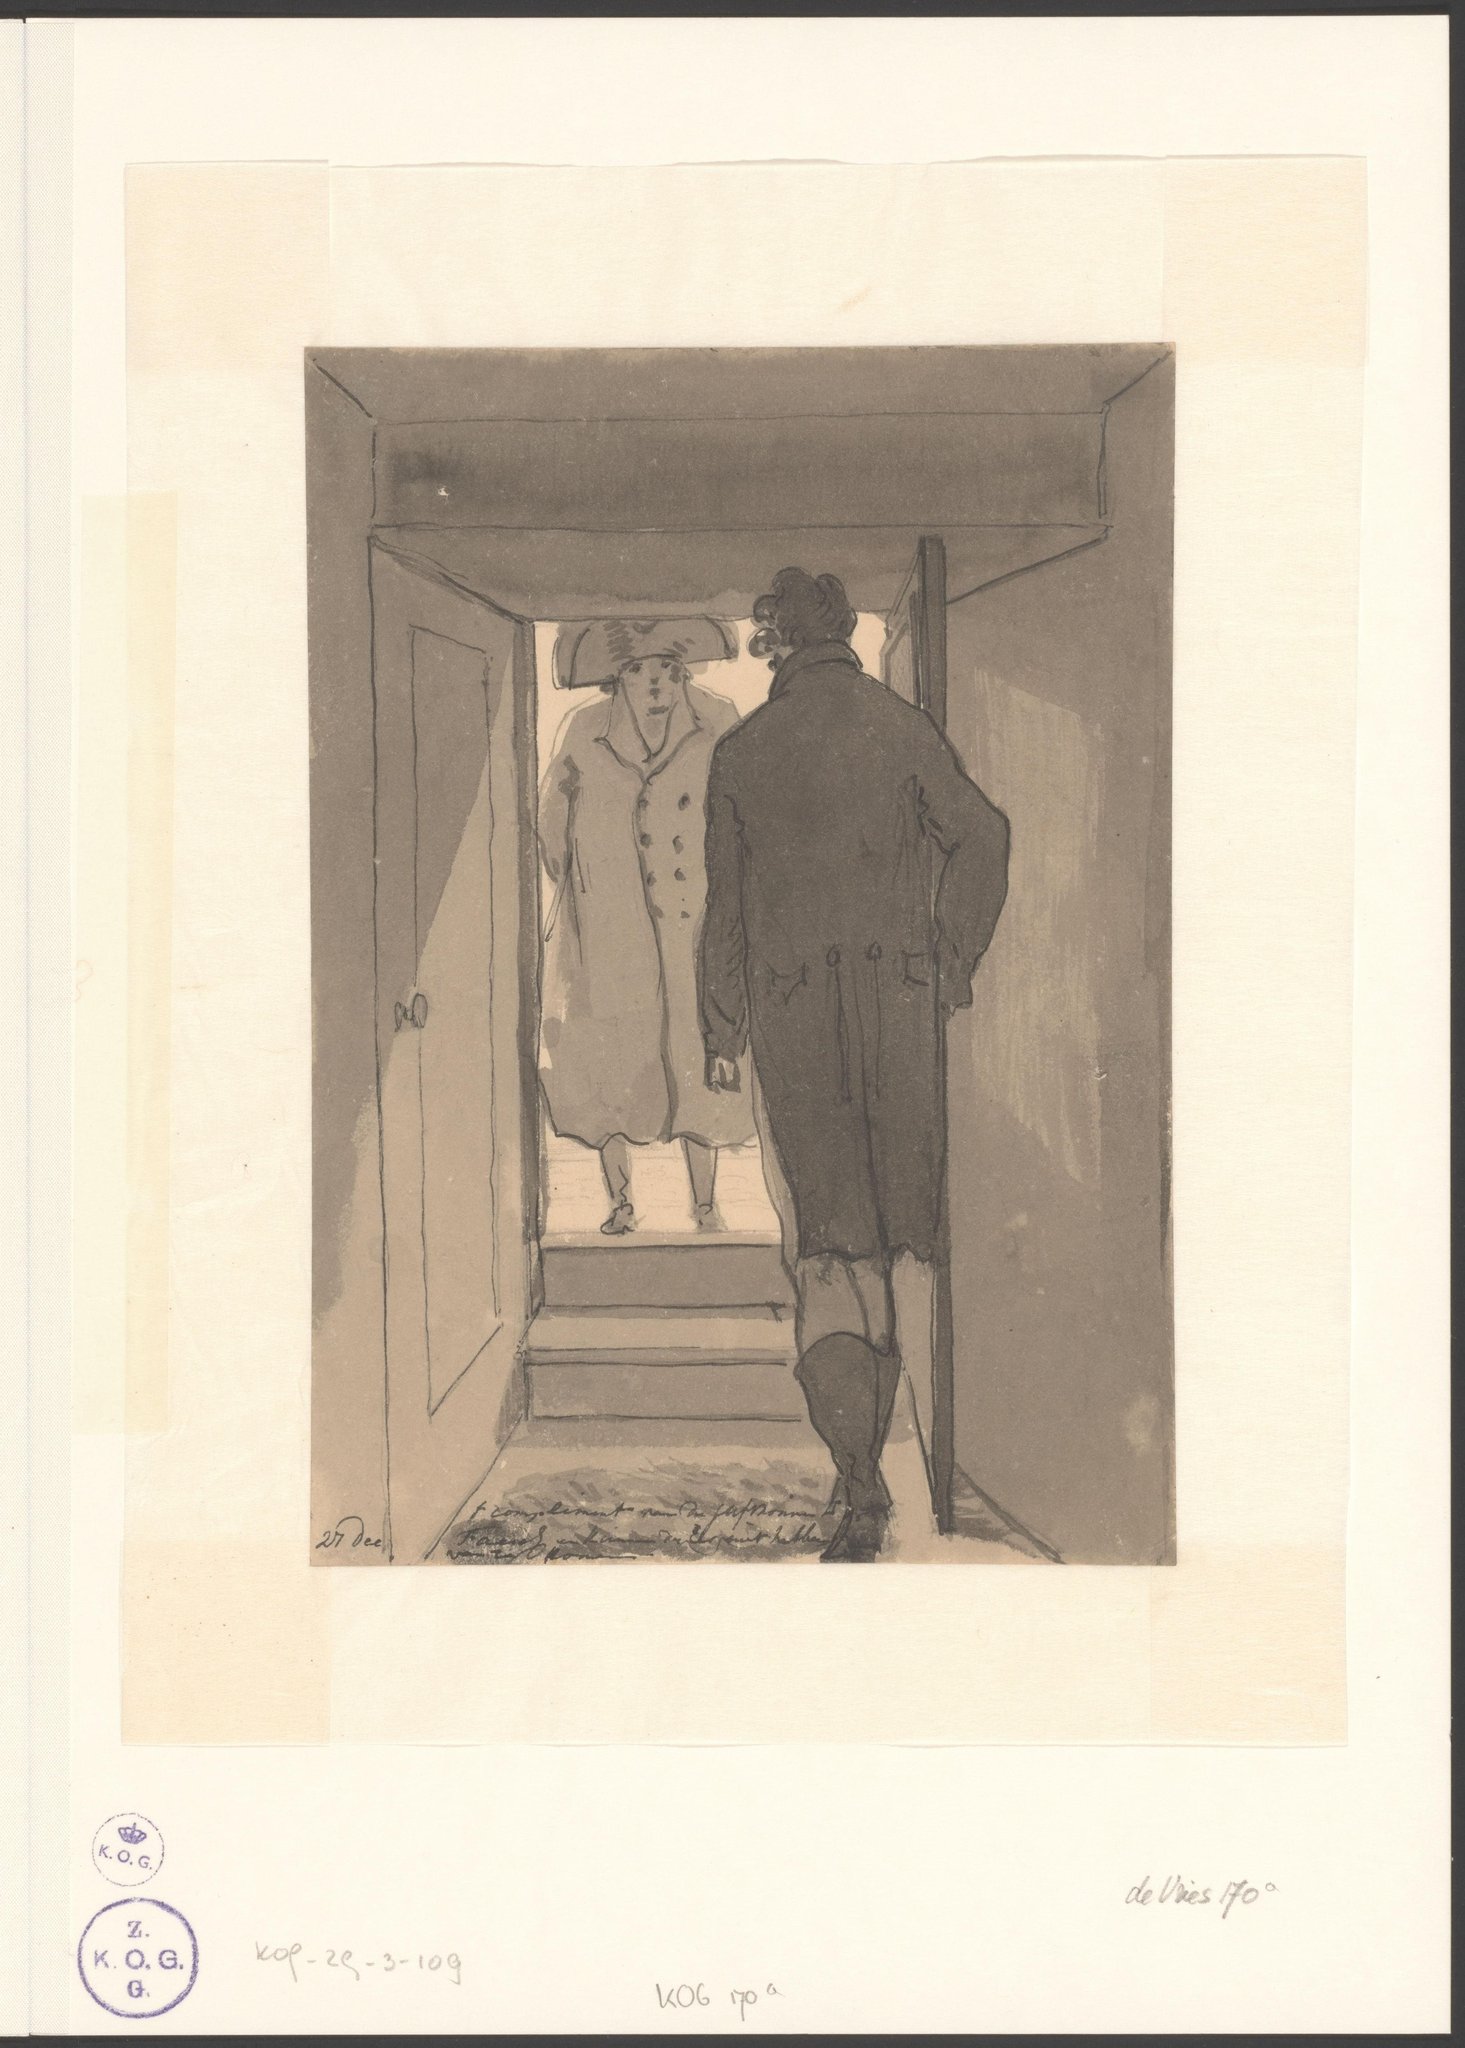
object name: drawing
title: Man brengt een boodschap over aan Christiaan Andriessen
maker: christiaan andriessen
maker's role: draughtsman, print maker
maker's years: 1775-1846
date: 1805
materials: ink, paper, pencil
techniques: brush, pen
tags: amsterdam, print maker, draughtsman, christiaan andriessen, head-gear: bicorne, bicorn, open door, messenger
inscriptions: inscription: ‘27 dec t complement van de jufvrouwen Faesch en kinderen (...)’, signature: ‘J Andriessen’, collector's mark: Lugt 1641, collector's mark: Lugt 1641a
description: Man brengt een boodschap over aan Christiaan Andriessen. De man vertelt dat de gezusters Faesch niet aanwezig zullen zijn bij de kunstbeschouwing bij de familie Andriessen de volgende dag.